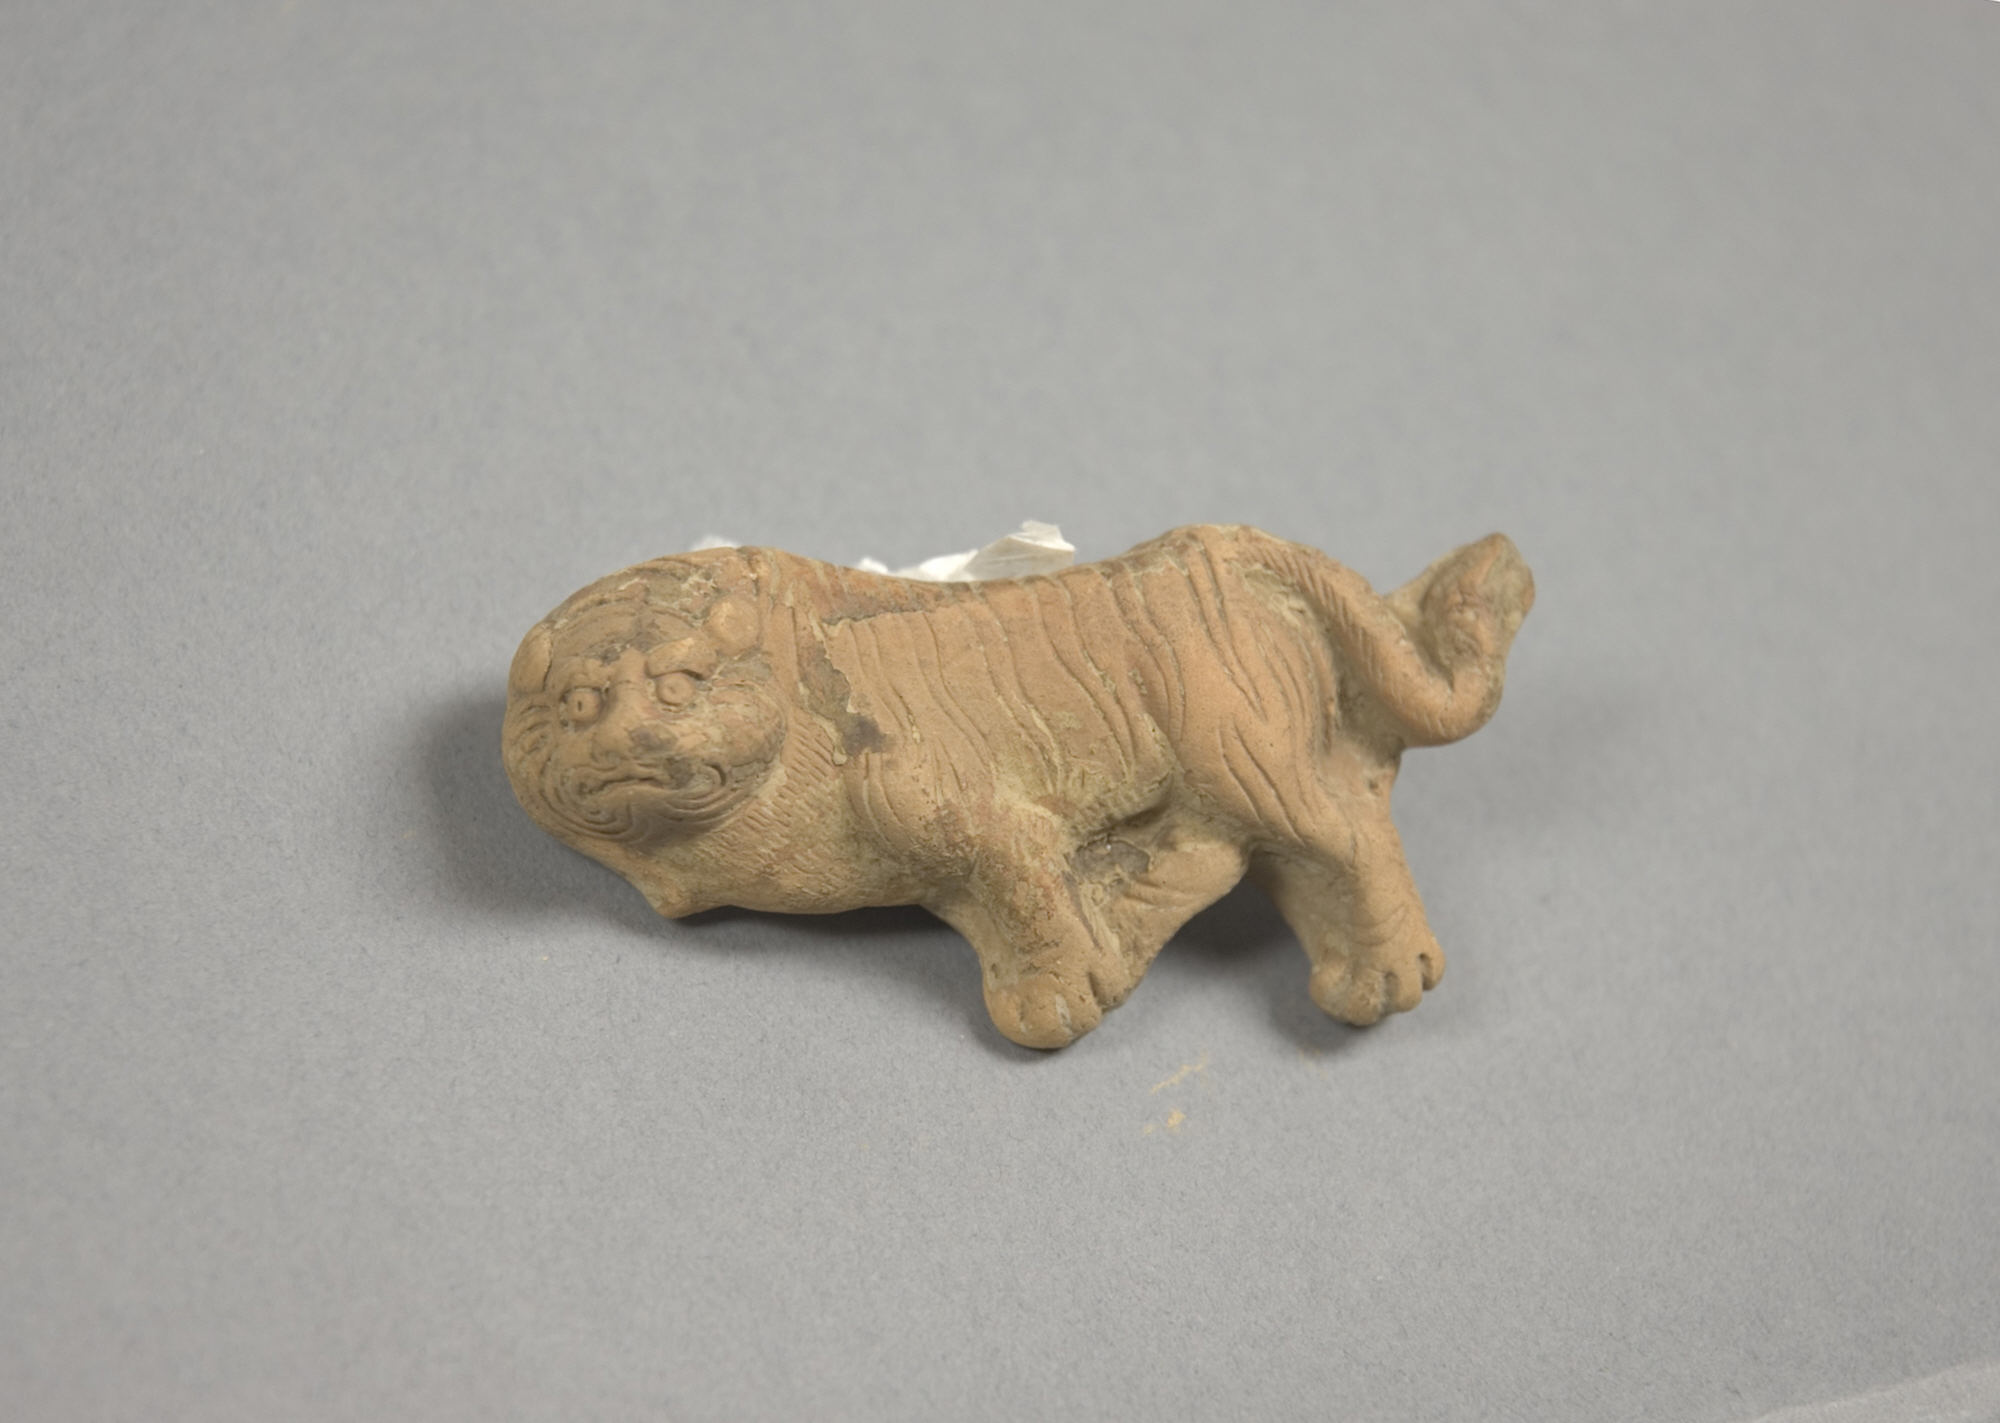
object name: figurine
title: Figure of a Tiger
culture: chinese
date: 960-1279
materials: pottery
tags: tigers